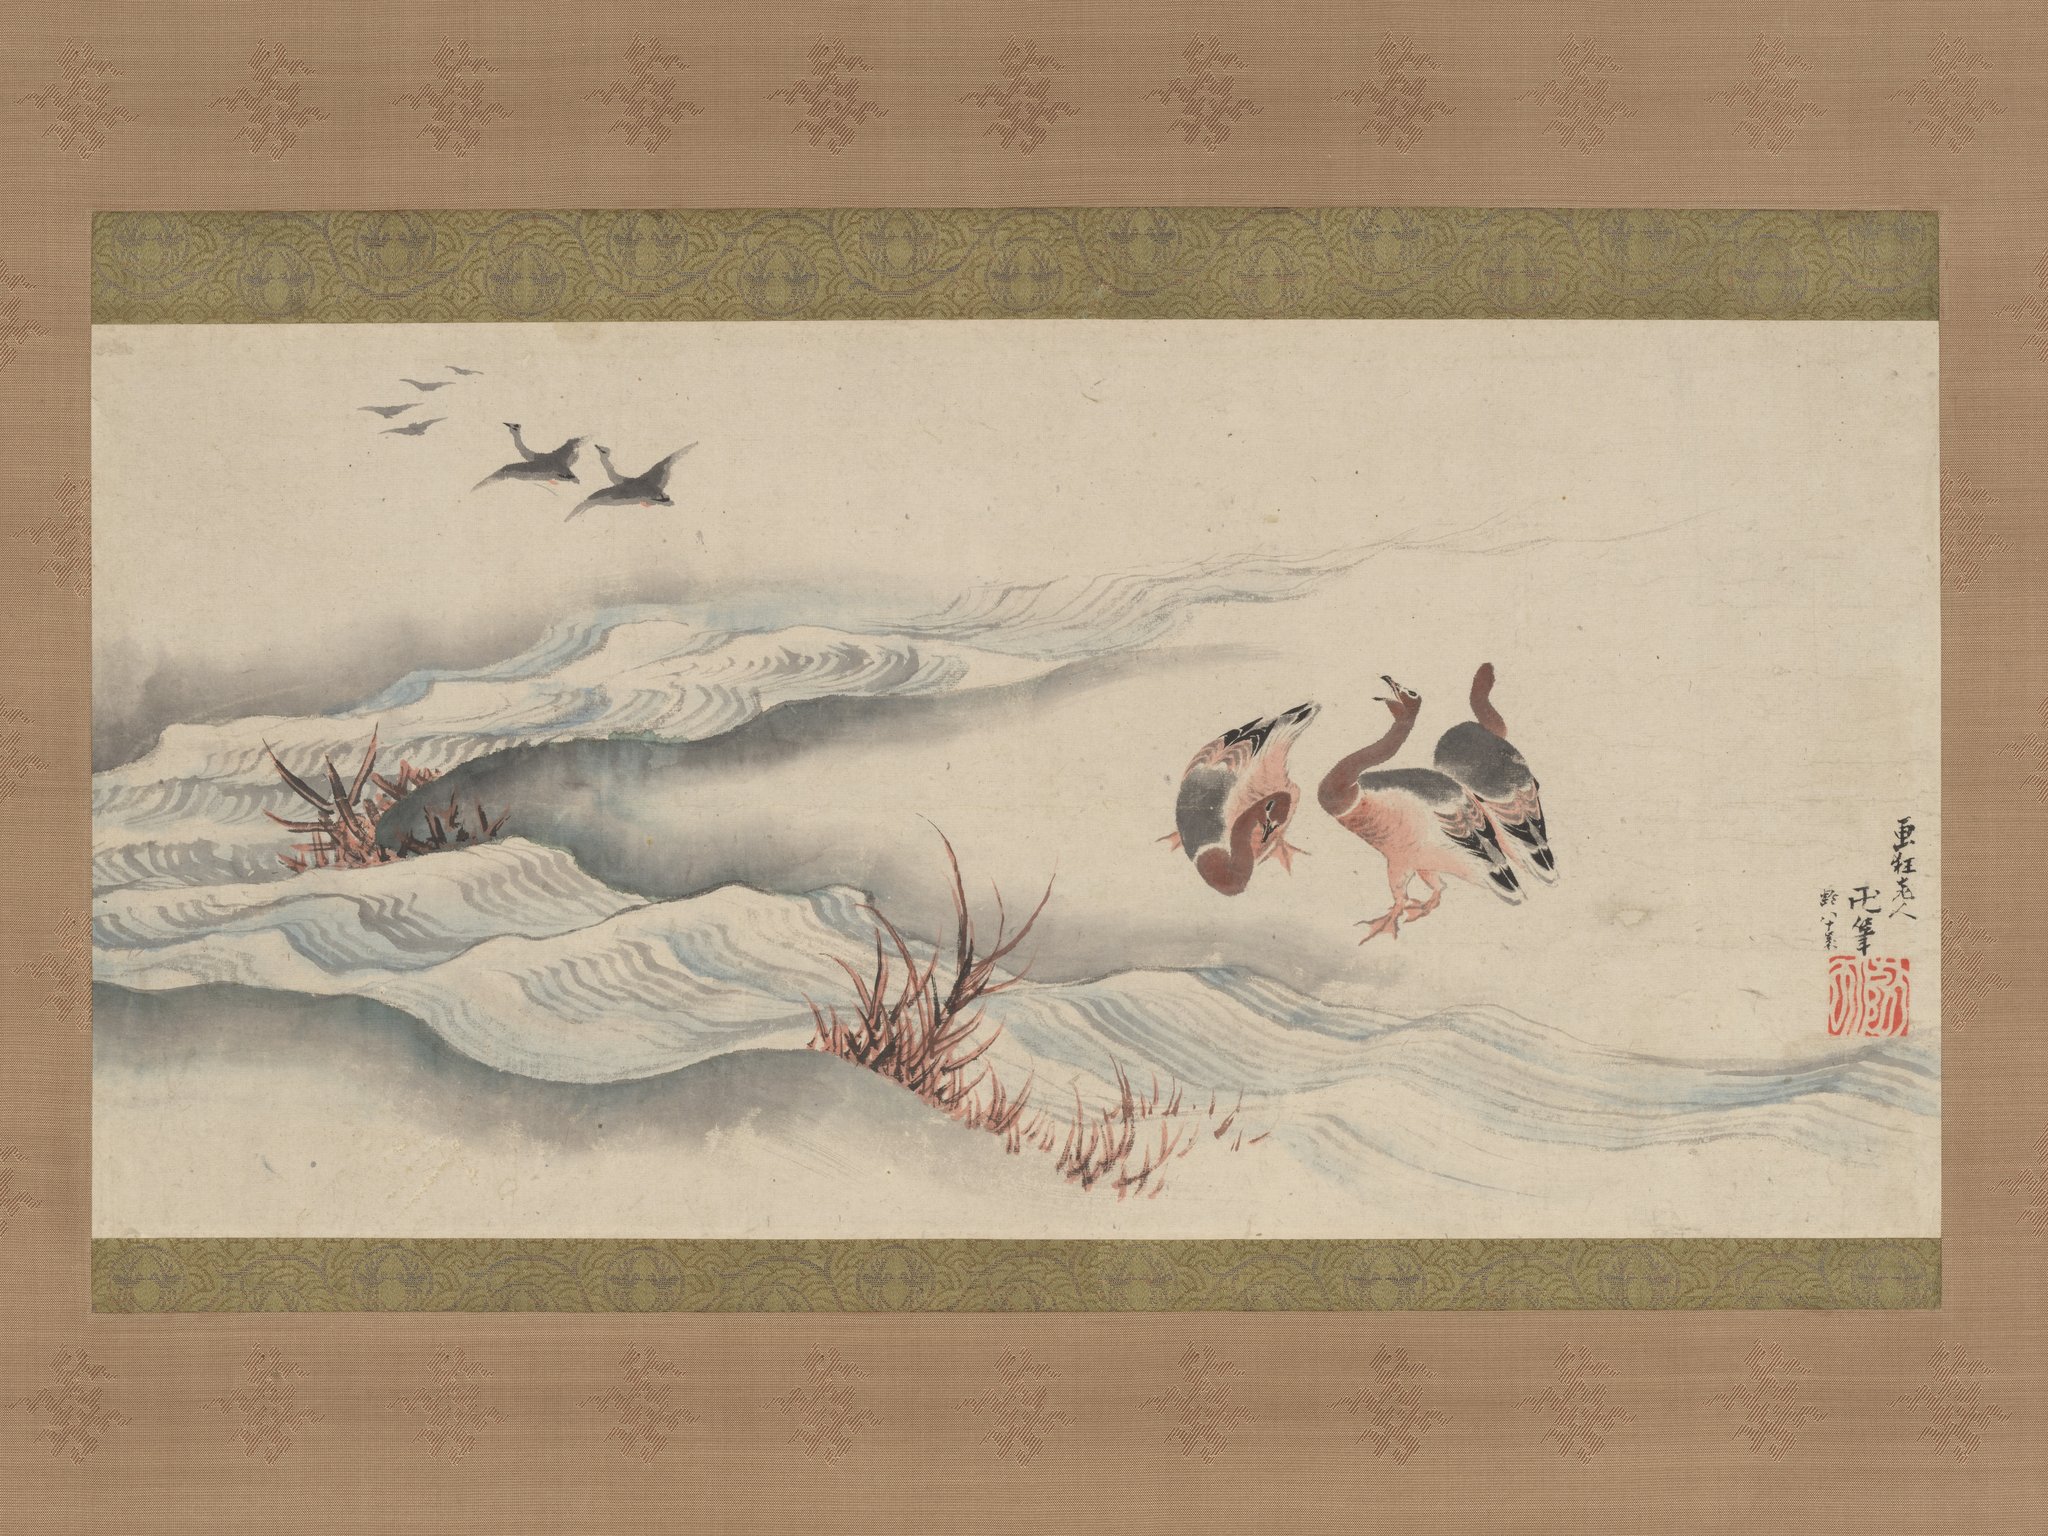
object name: hanging scroll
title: Wild Geese and Water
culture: japanese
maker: katsushika hokusai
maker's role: artist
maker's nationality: japanese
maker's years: 1760-1849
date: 1839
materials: ink, paper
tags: geese,streams